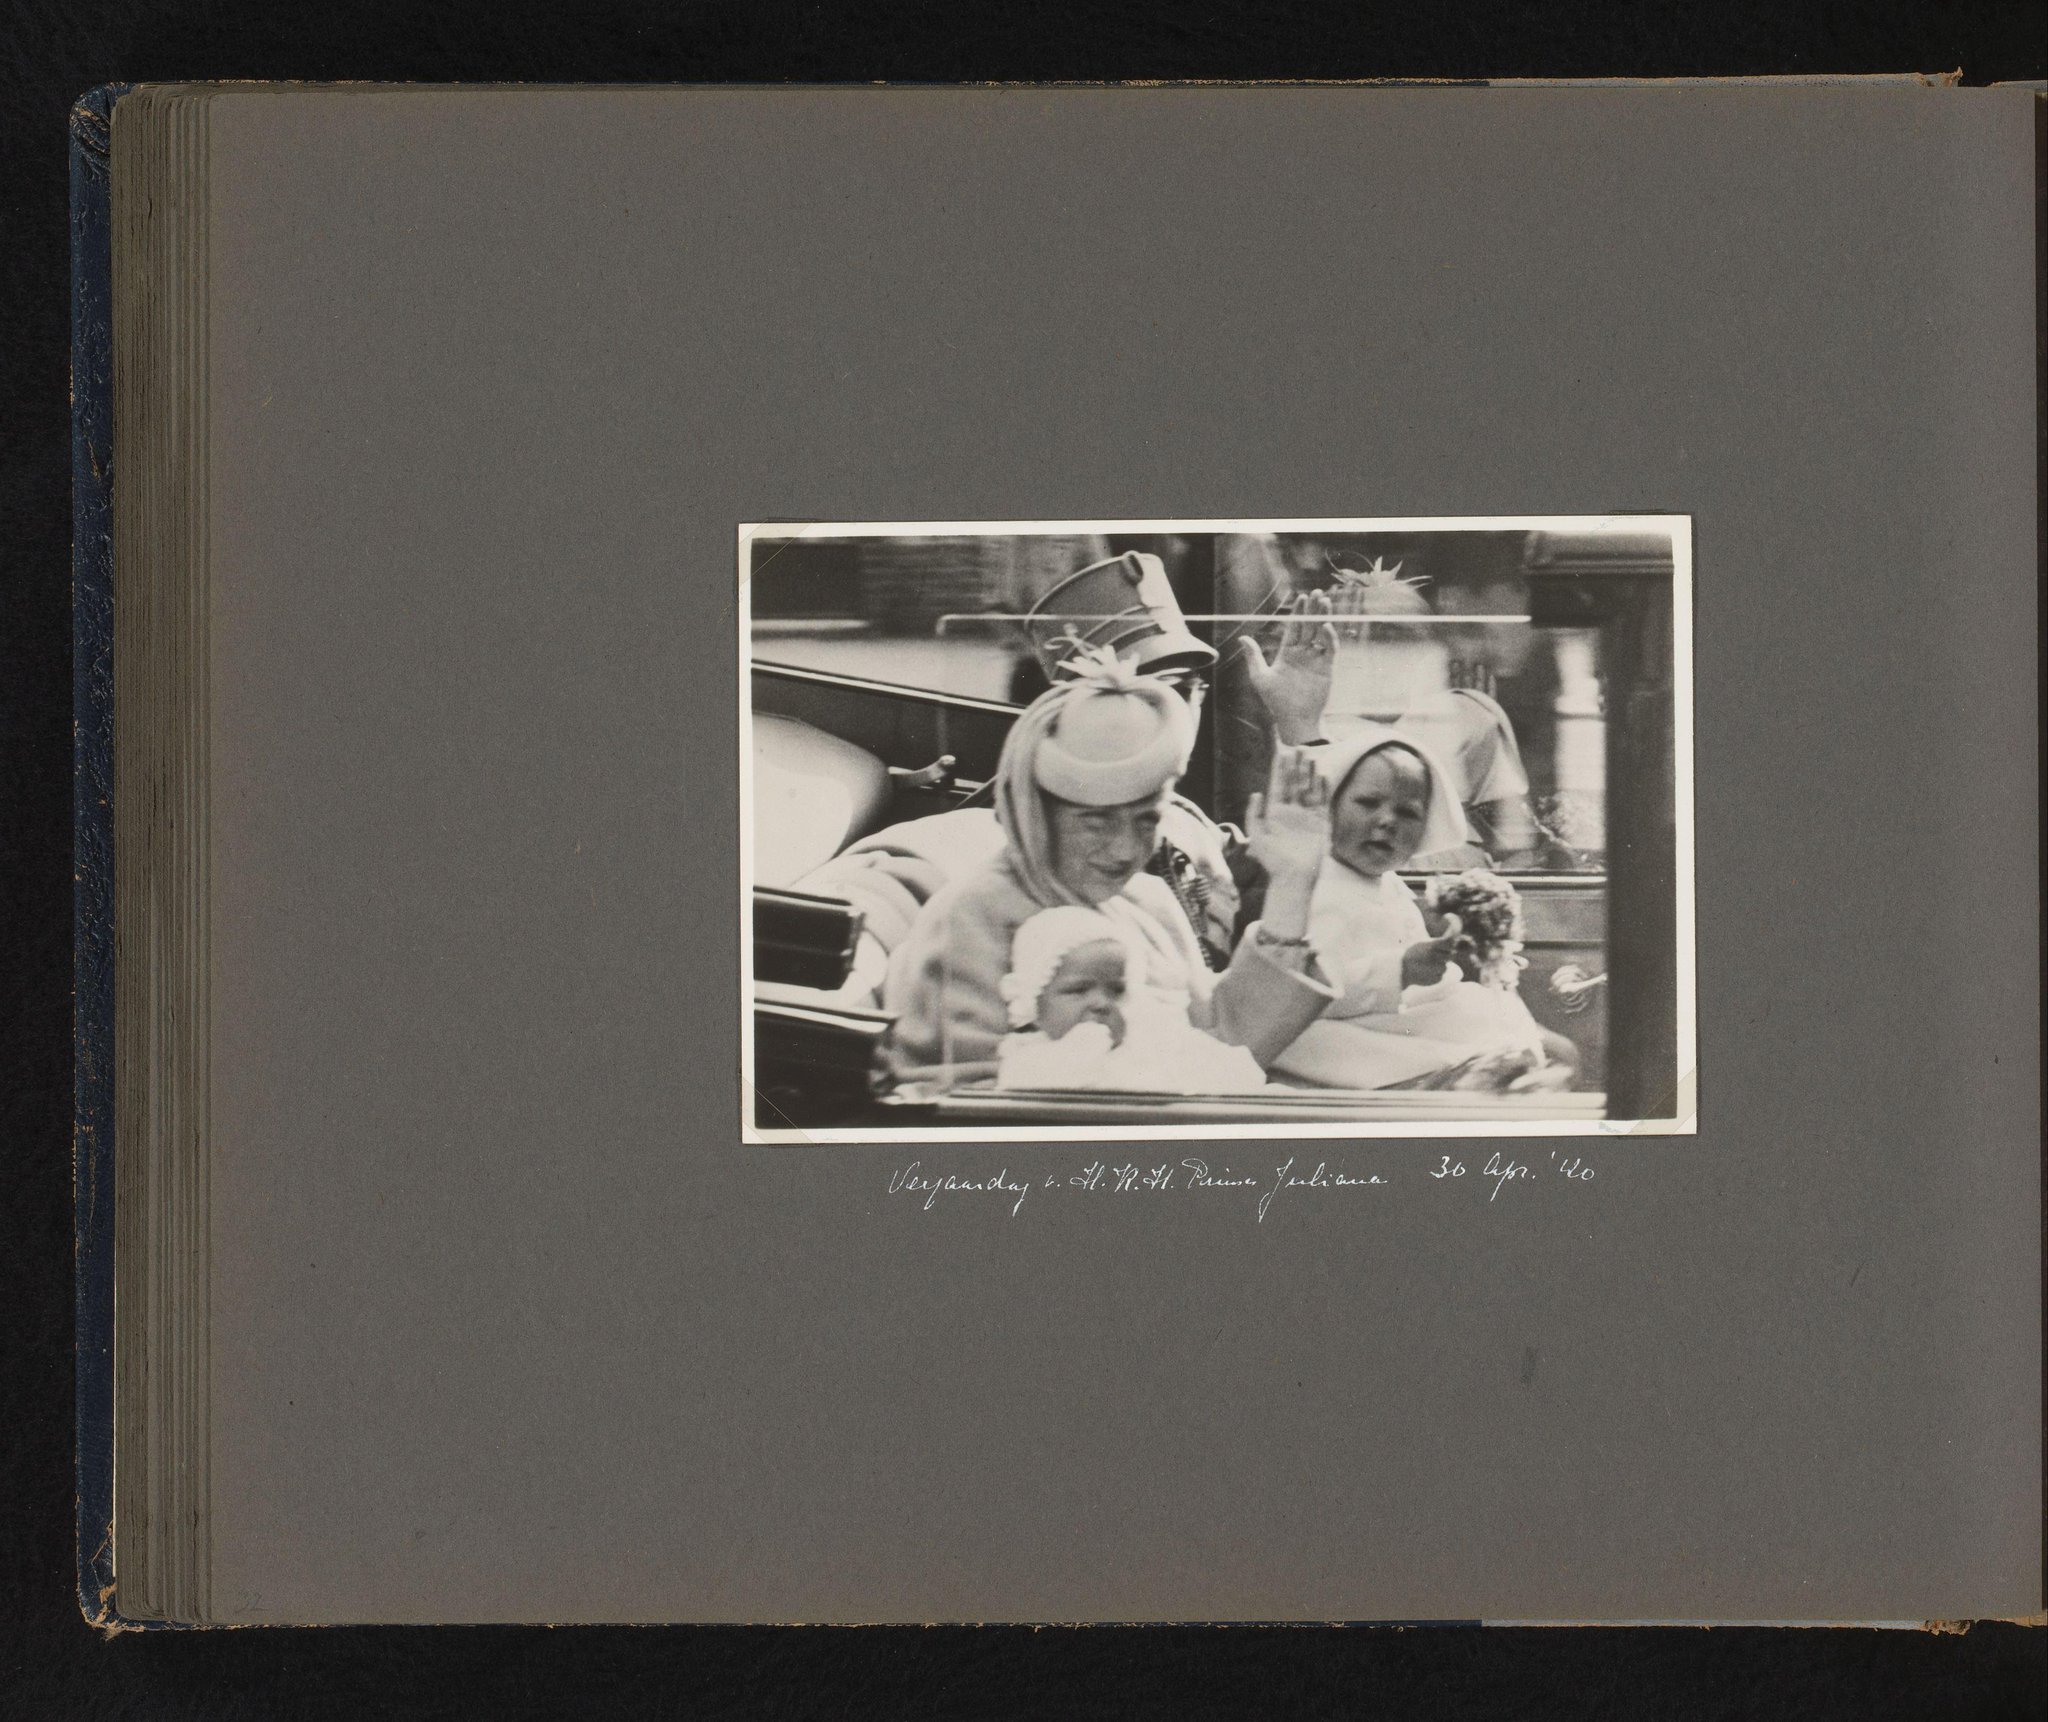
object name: album leaf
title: Koninklijke Familie op de verjaardag van Juliana, 1940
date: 1940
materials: cardboard, photographic support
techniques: gelatin silver print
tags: utrecht, bernhard (prins der nederlanden), beatrix (koningin der nederlanden), juliana of the netherlands, parents with their children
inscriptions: date: ‘Verjaardag v. H.K.H. Prinses Juliana. 30 Apr. '40’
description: Albumblad met een foto van de Koninklijke Familie in een auto op de verjaardag van prinses Juliana, 30 april 1940. Onderdeel van fotoalbum over het familieleven van de leden van het Koninklijk Huis tussen 1937-1945.